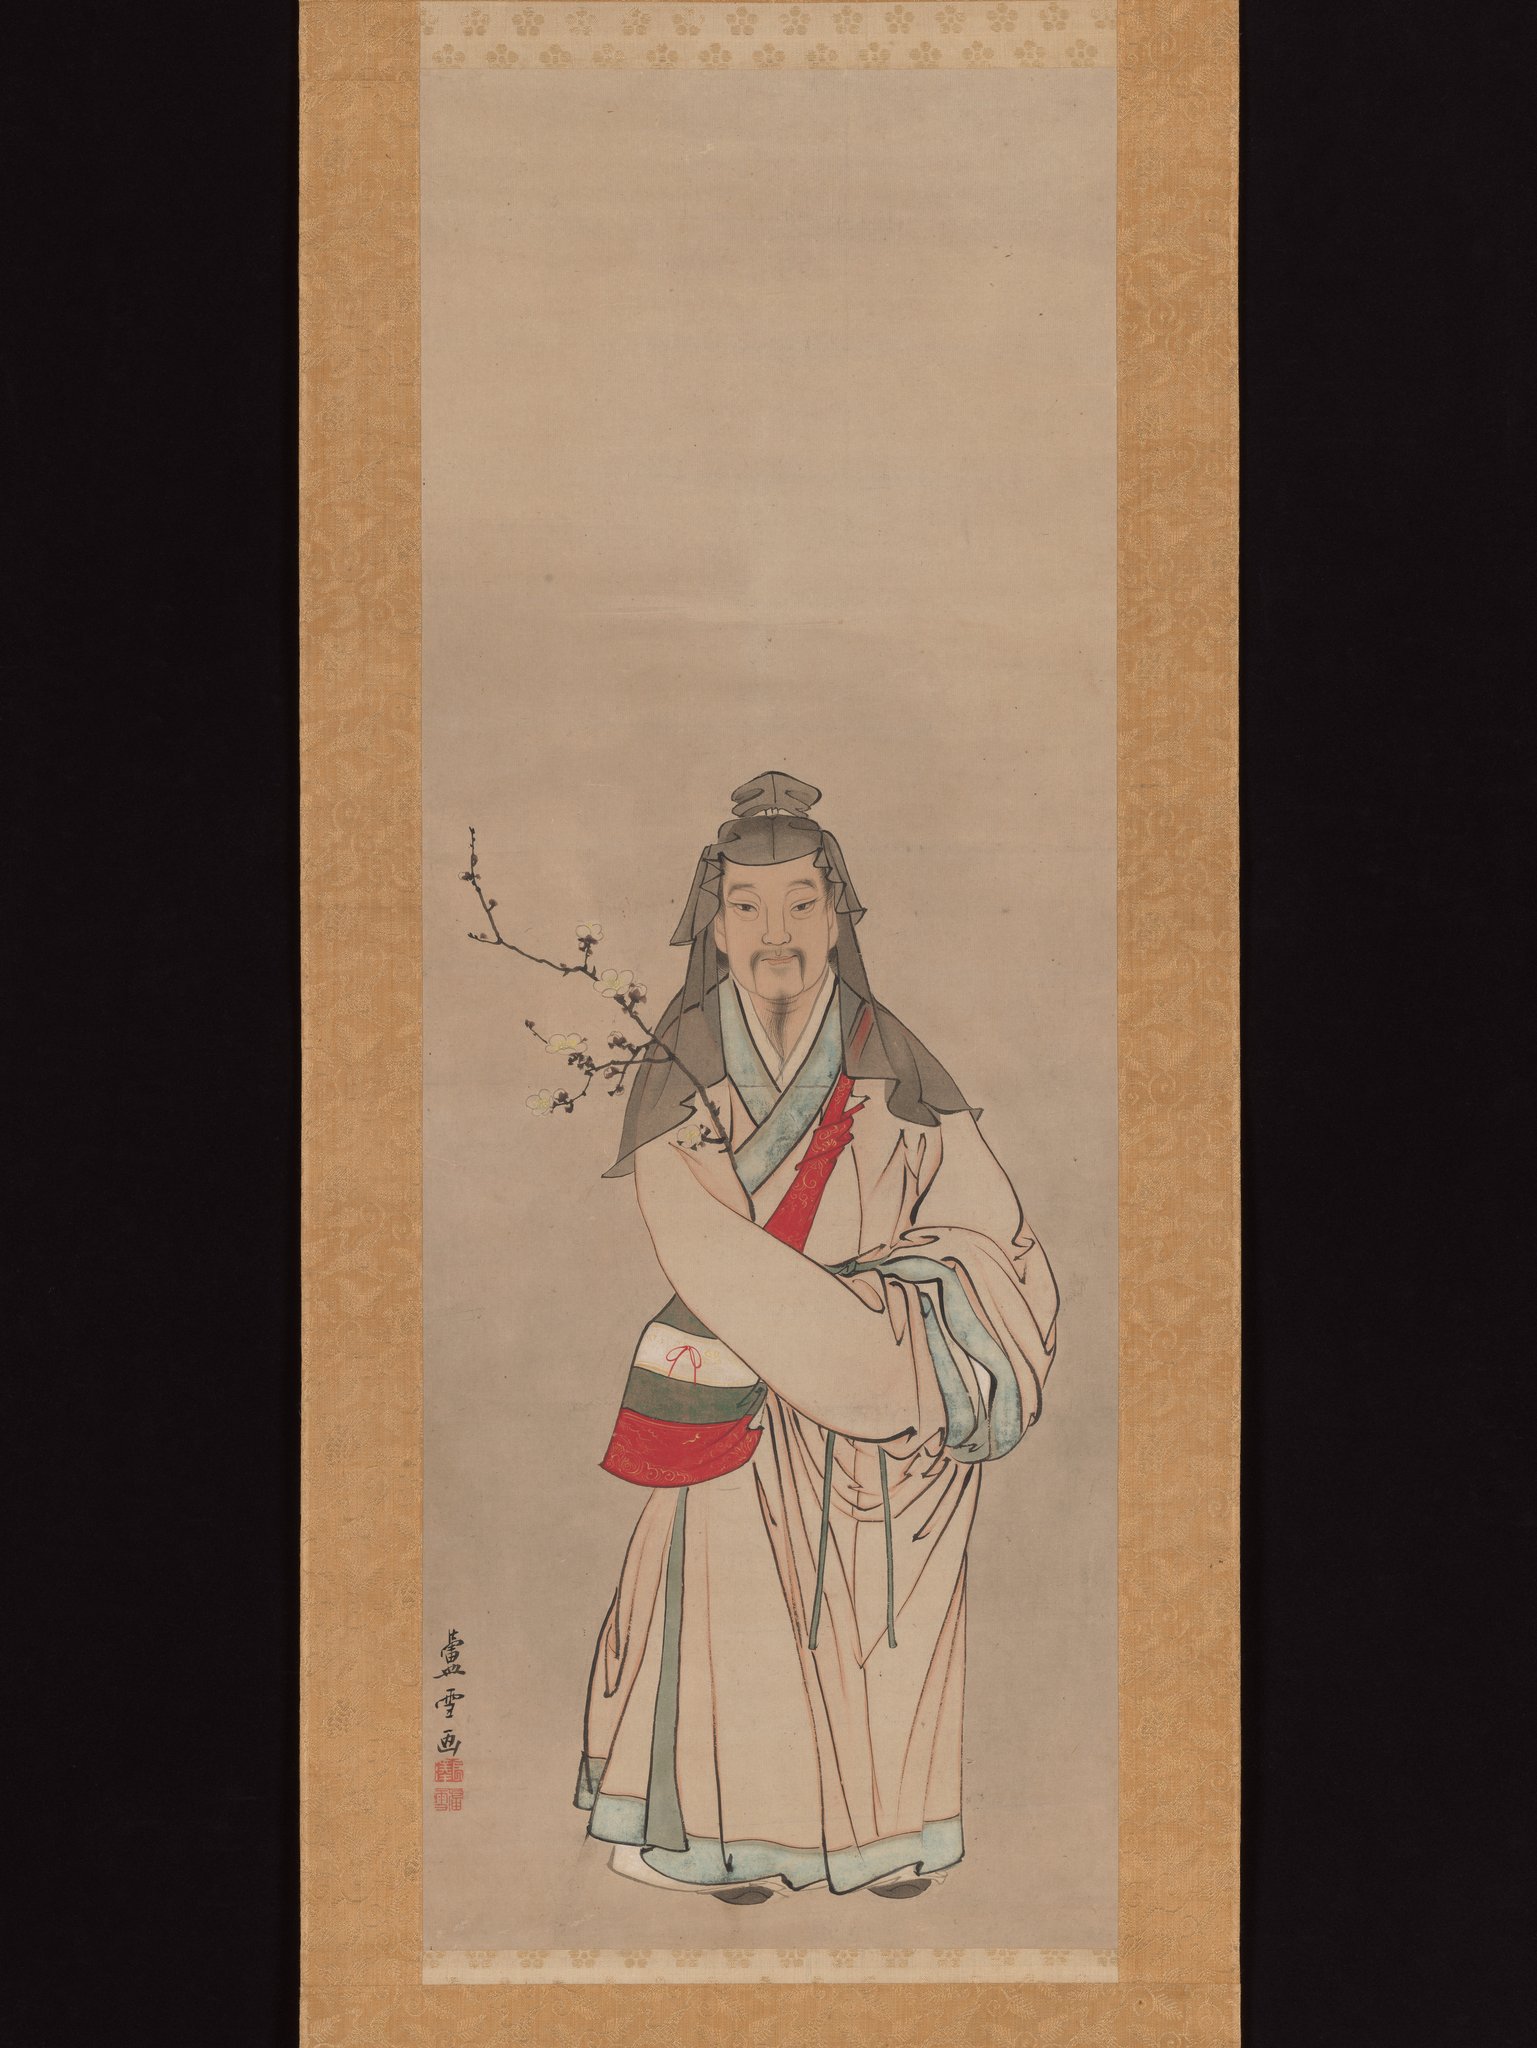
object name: hanging scroll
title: Tenjin Traveling to China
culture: japanese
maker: nagasawa rosetsu 長澤蘆雪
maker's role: artist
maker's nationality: japanese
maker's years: 1754-1799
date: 1787-1788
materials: ink, paper